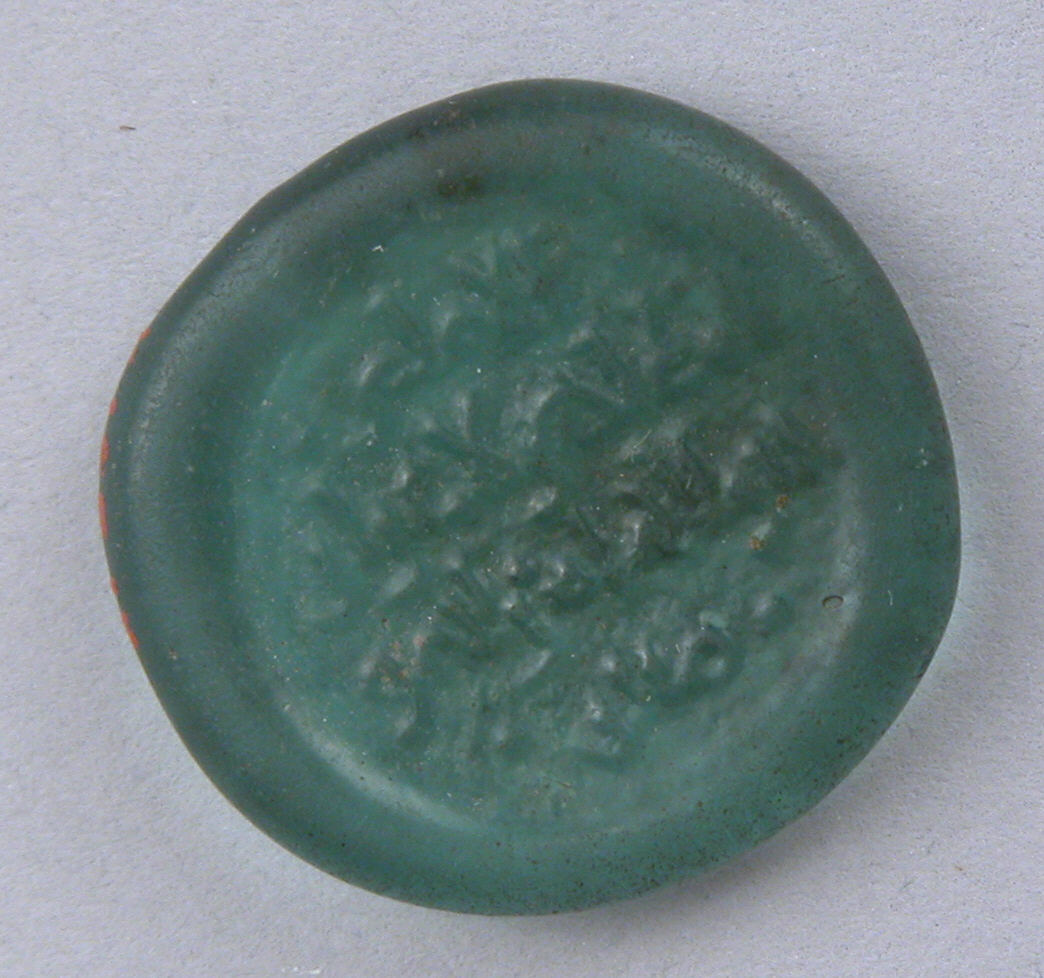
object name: coin weight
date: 1001-1100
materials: glass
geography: egypt